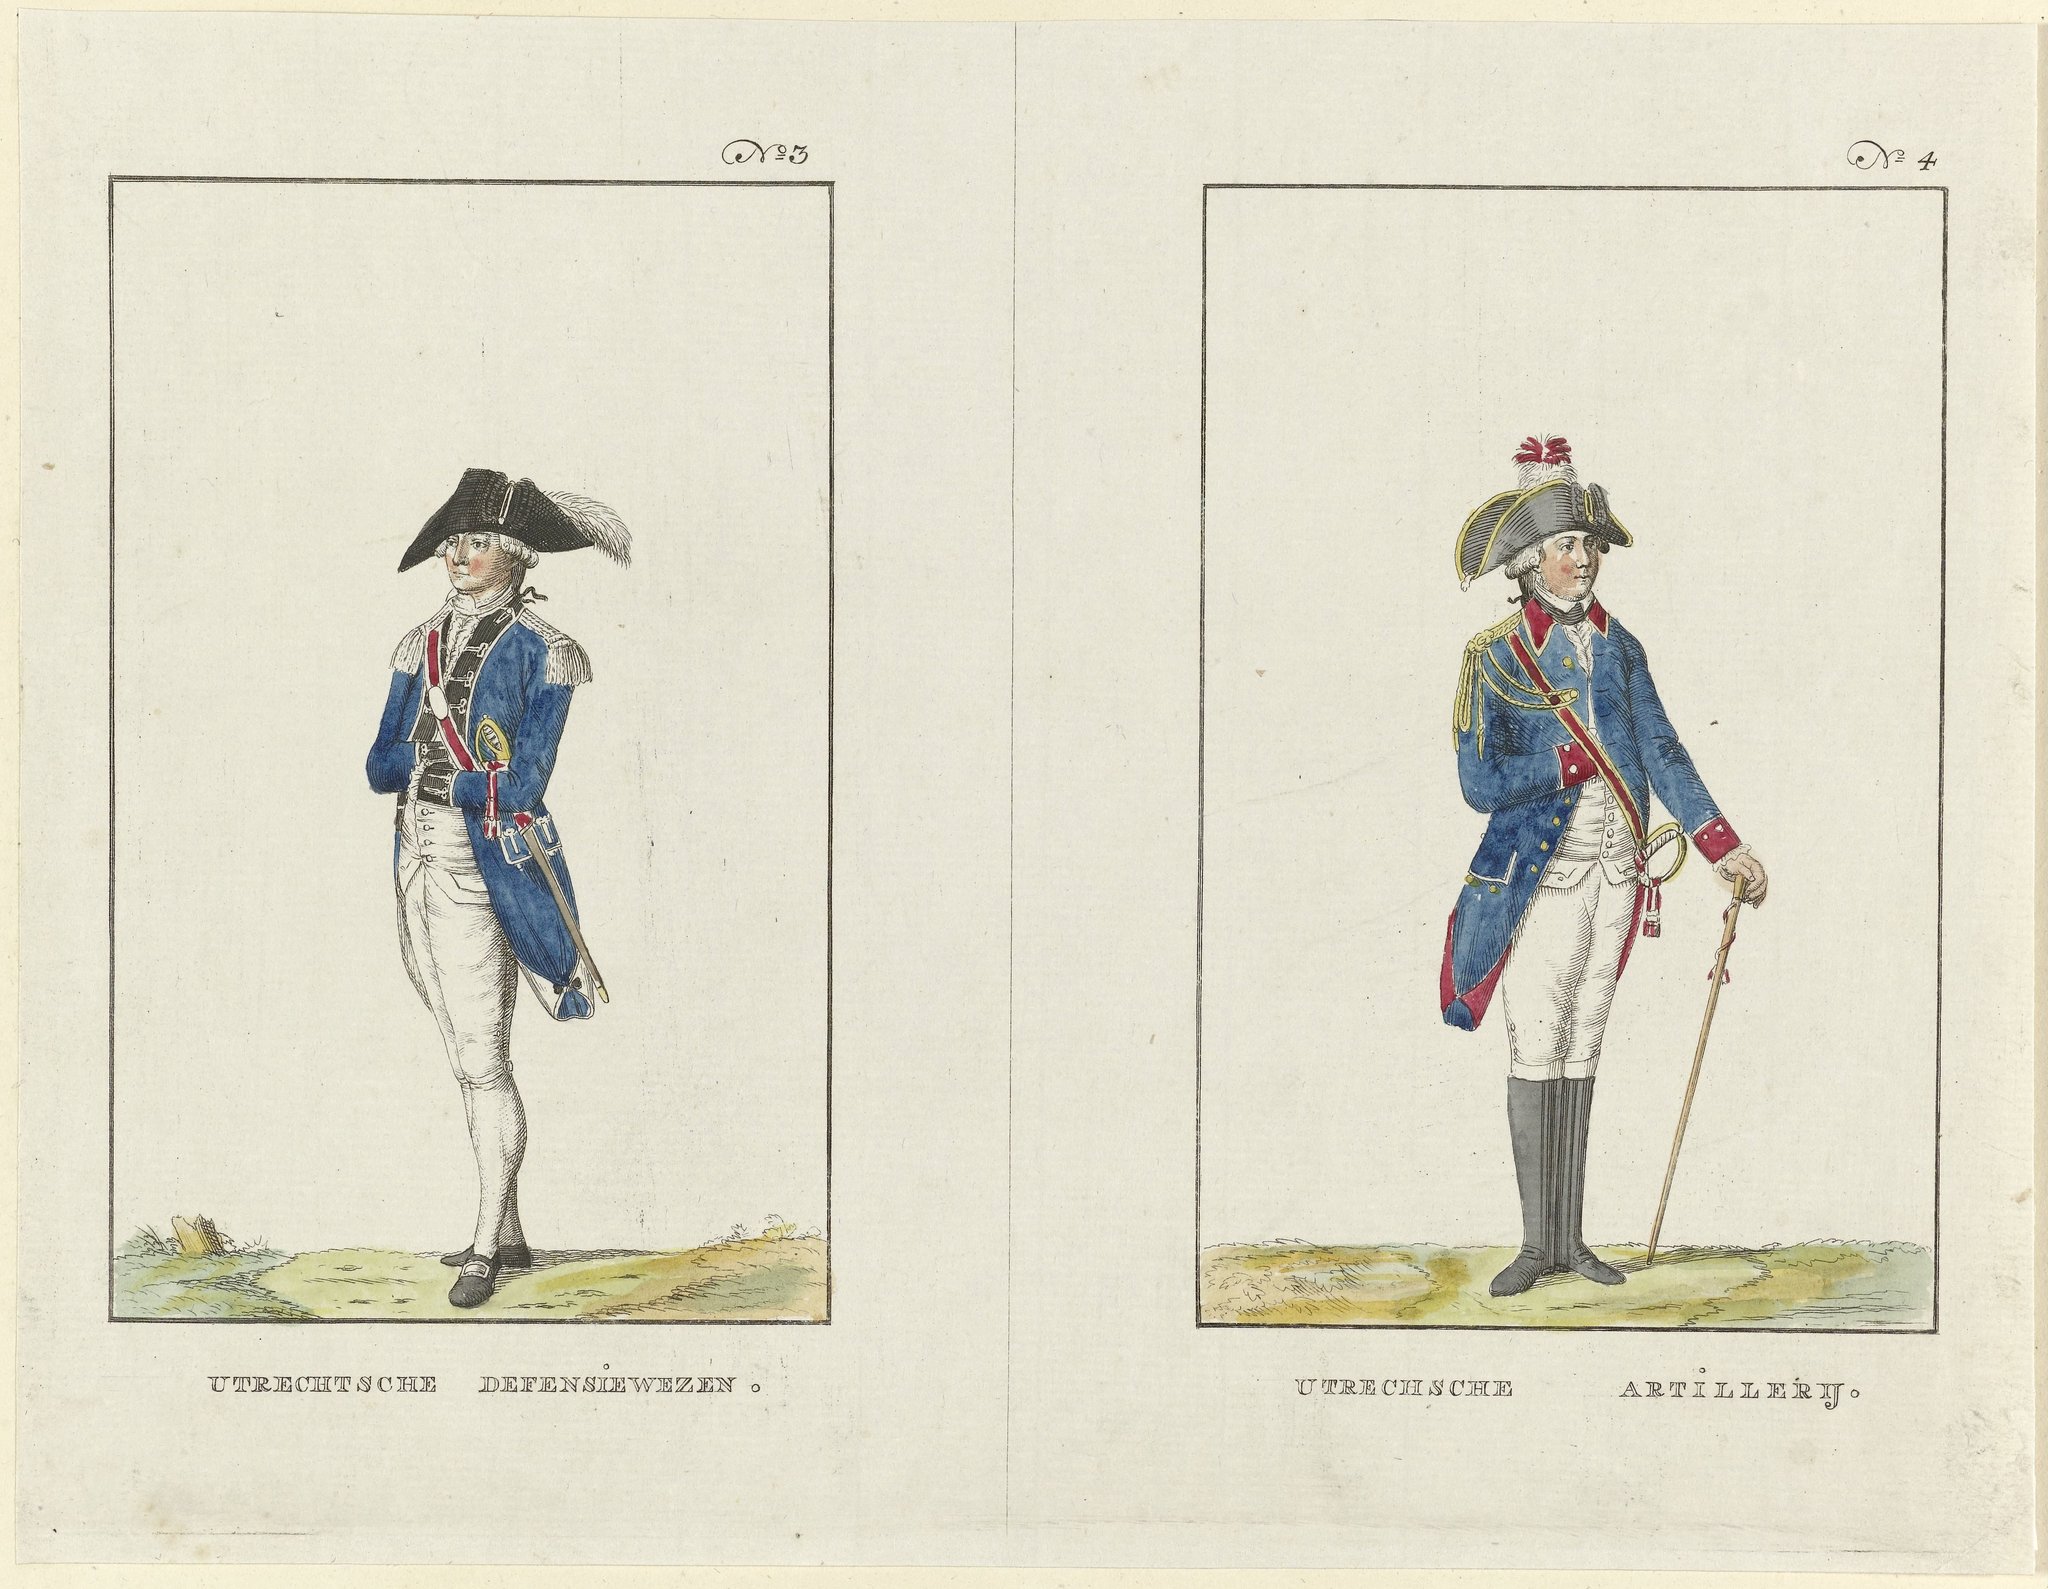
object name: costume print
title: Utrechtsche defensiewezen / Utrechtsche Artillerij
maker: Anonymous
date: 1782-1784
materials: paper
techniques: engraving, etching, hand coloring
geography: northern netherlands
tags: (military) uniforms (+ citizen soldiery, civil guard, citizen militia), utrecht, patriots (1780-1795)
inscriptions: collector's mark: Lugt 2228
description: Blad met twee uniformvoorstellingen genummerd No. 3 en 4. Links het uniform van het Utrechtse Defensiewezen, rechts het uniform van de artillerie te Utrecht. Pendant van het blad met de nrs. 1 en 2 van de verschillende monteringen (uniformen) van patriotse schutterijen en burgerkorpsen in Nederland in 1784.